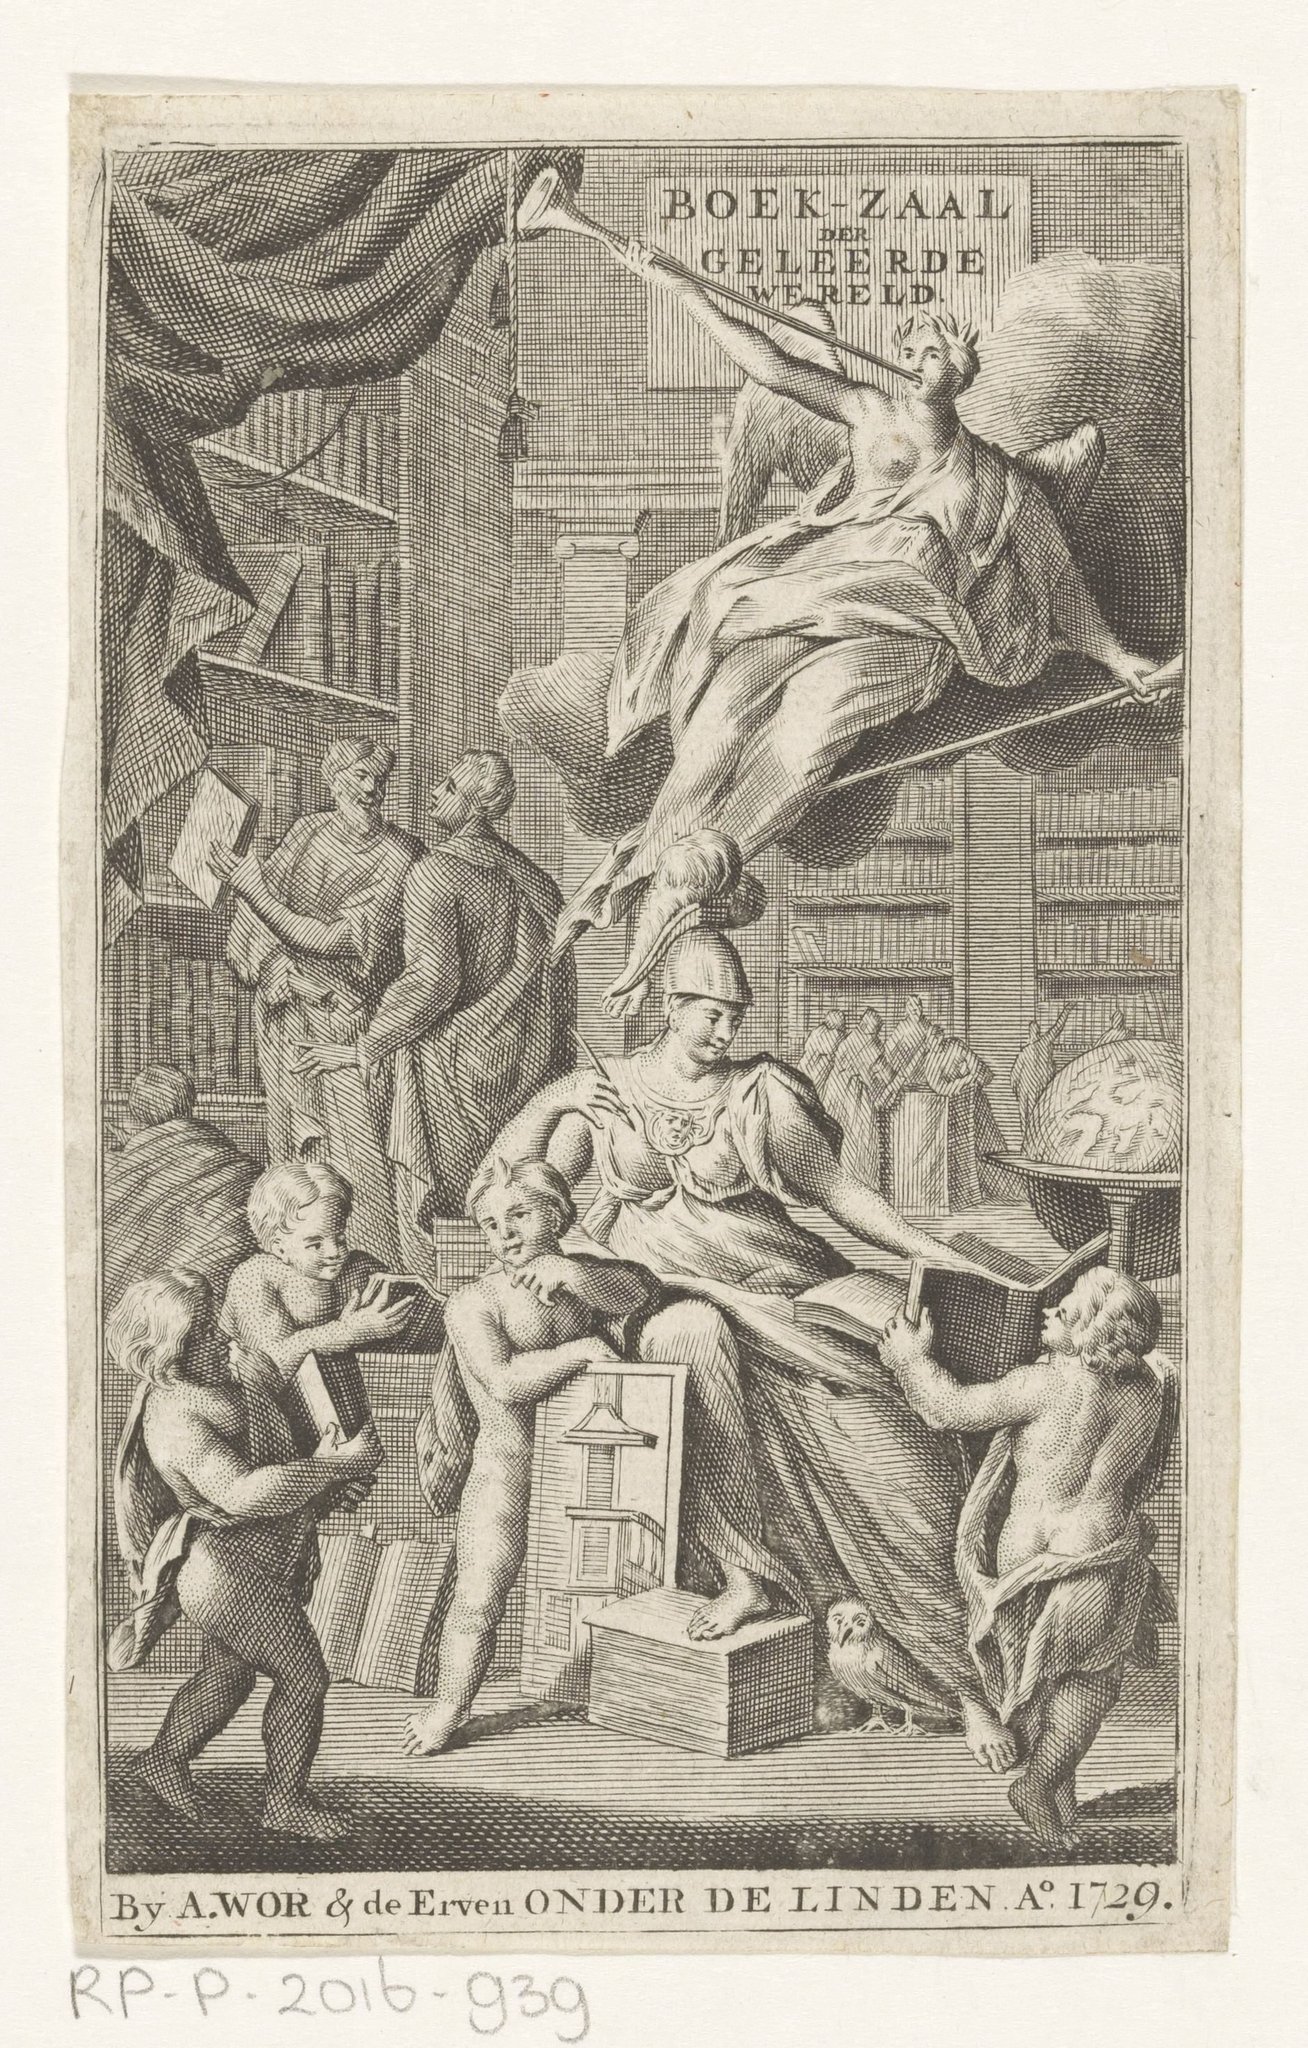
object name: titelblad, titelpagina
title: Minerva en geleerden in bibliotheek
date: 1729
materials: paper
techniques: engraving, etching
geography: amsterdam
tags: (story of) minerva (pallas, athena), scholar, philosopher, public library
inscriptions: collector's mark: Lugt 2228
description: Titelpagina voor het tijdschrift: Maandelyke uittreksels, of Boekzaal der geleerde waereld, uitgegeven door Gerard onder de Linden en diens opvolgers tussen 1715-1864.